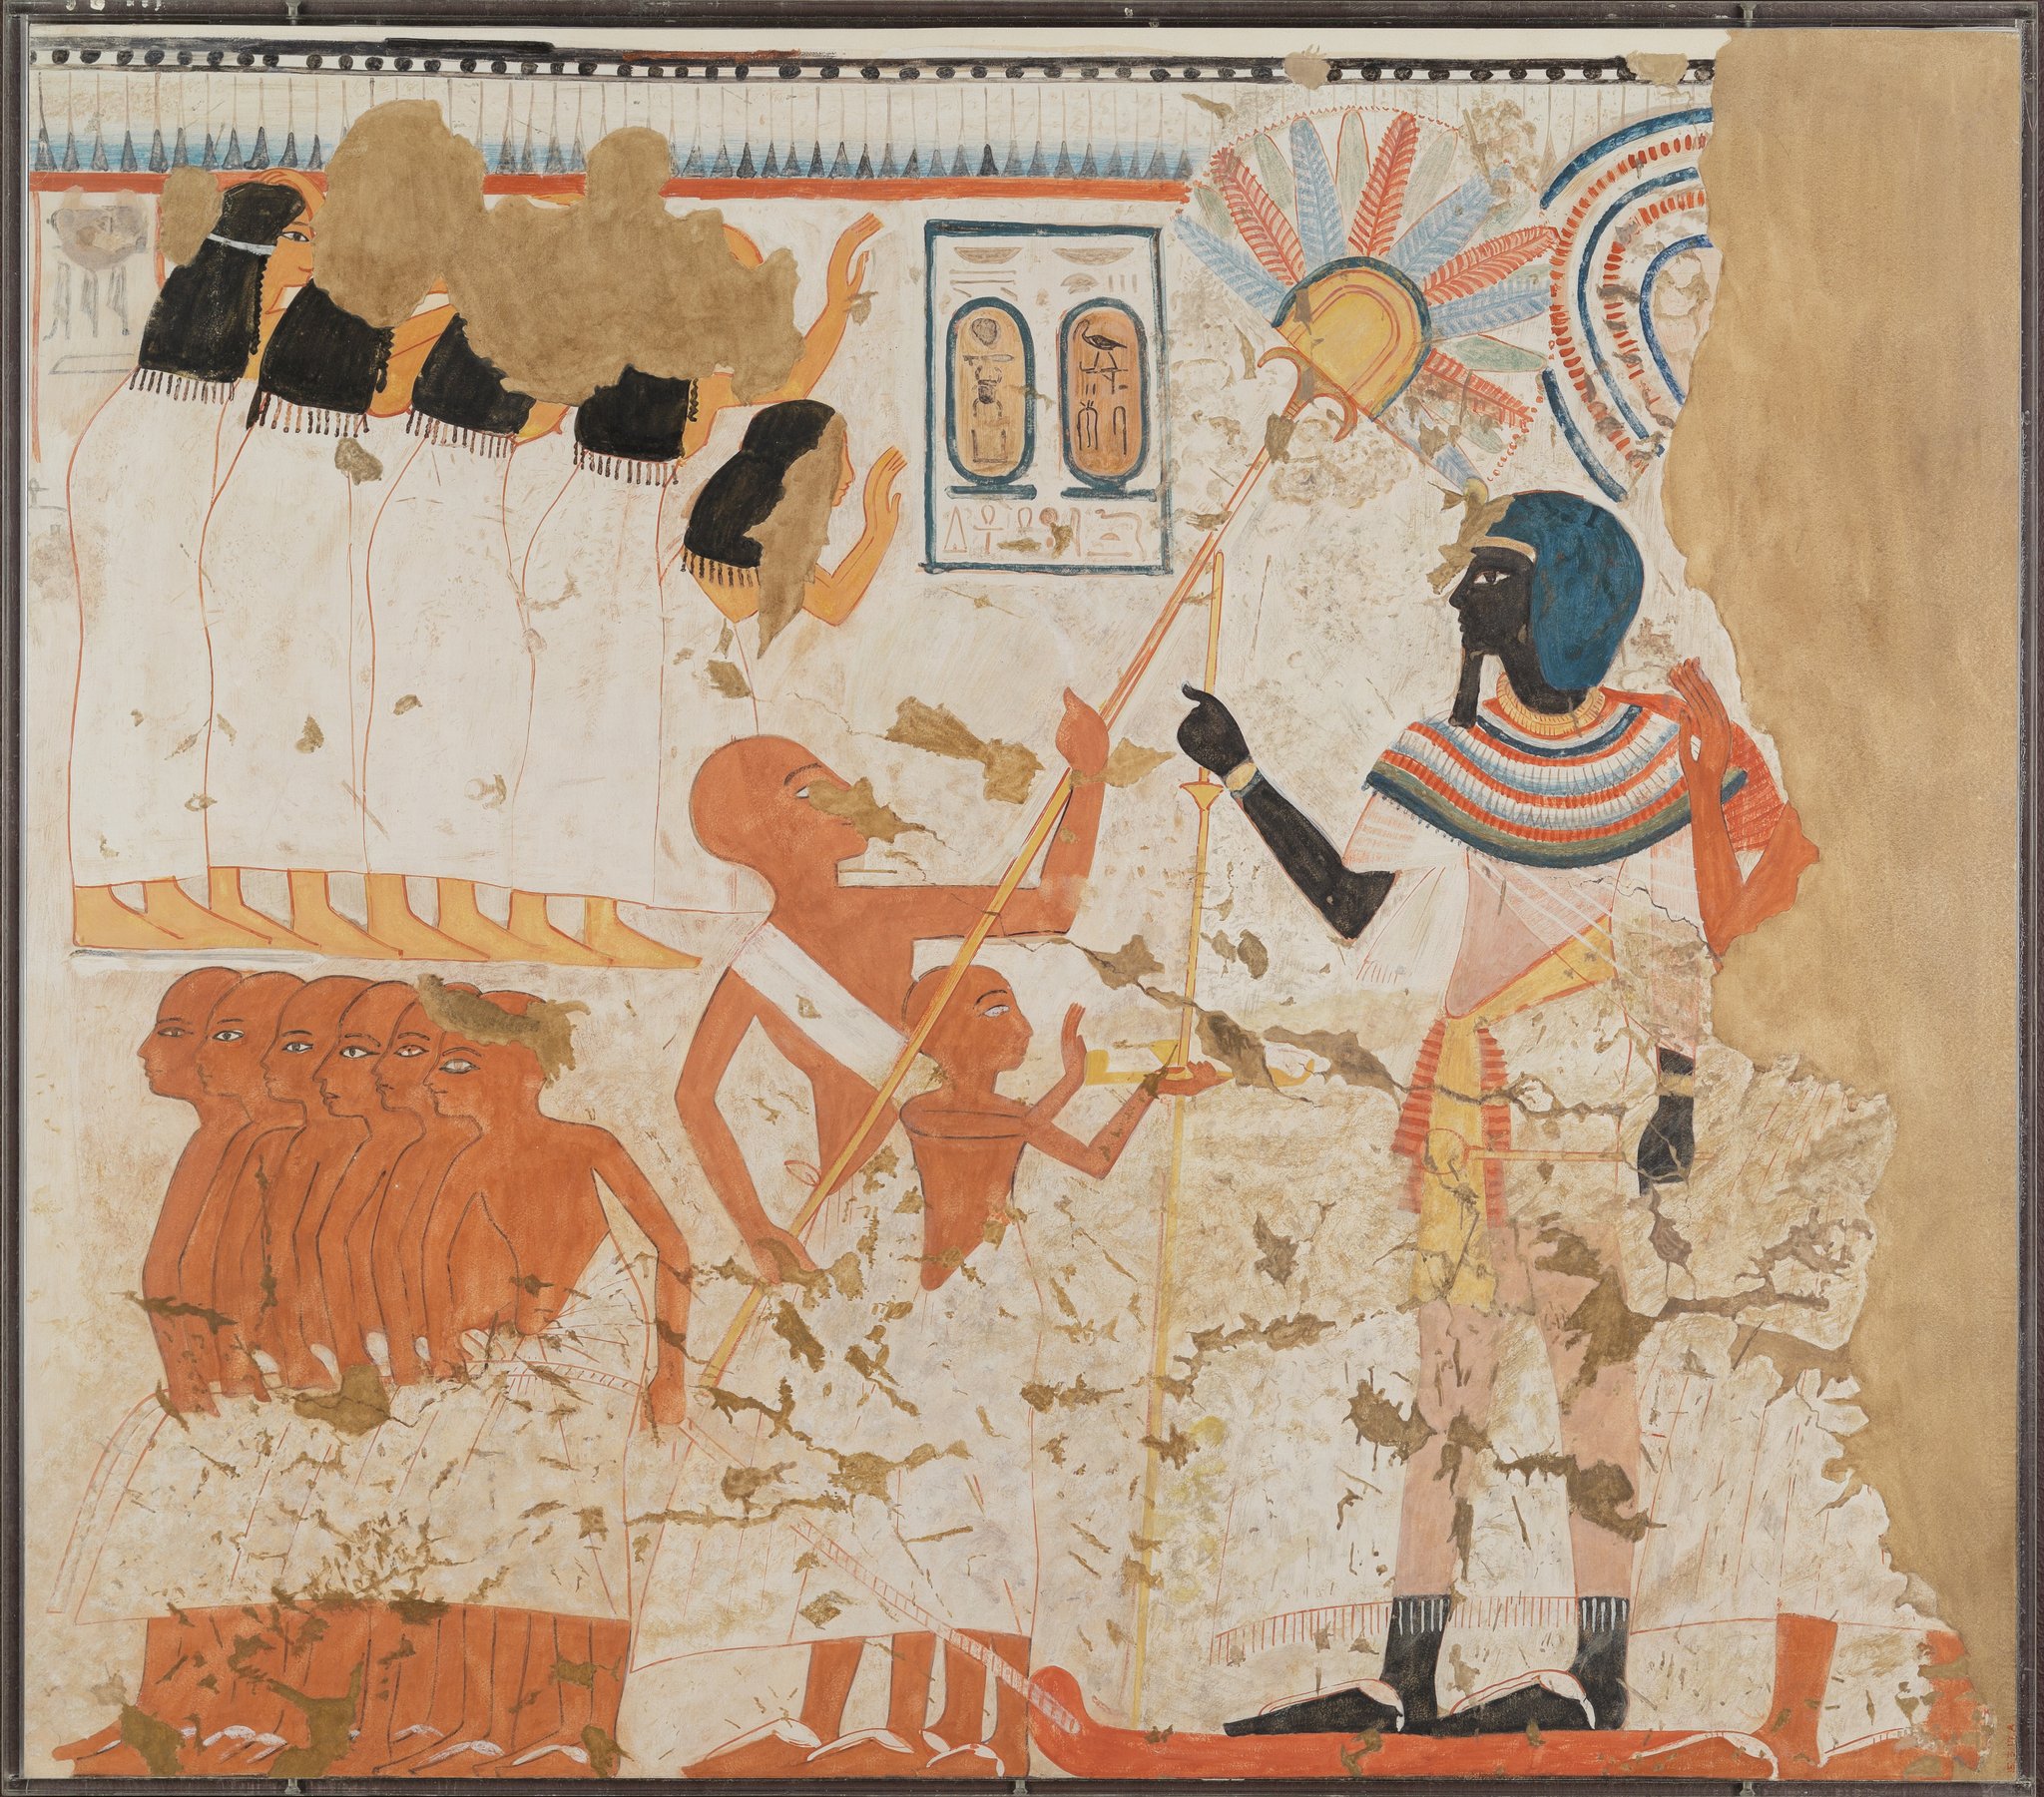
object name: facsimile, userhat tt 51, thutmose i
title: Dragging a Statue of Thutmose I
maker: norman de garis davies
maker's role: artist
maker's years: 1865-1941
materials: paper, paint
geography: egypt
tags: cartouches,men,women,hieroglyphs,walk-like-egyptian